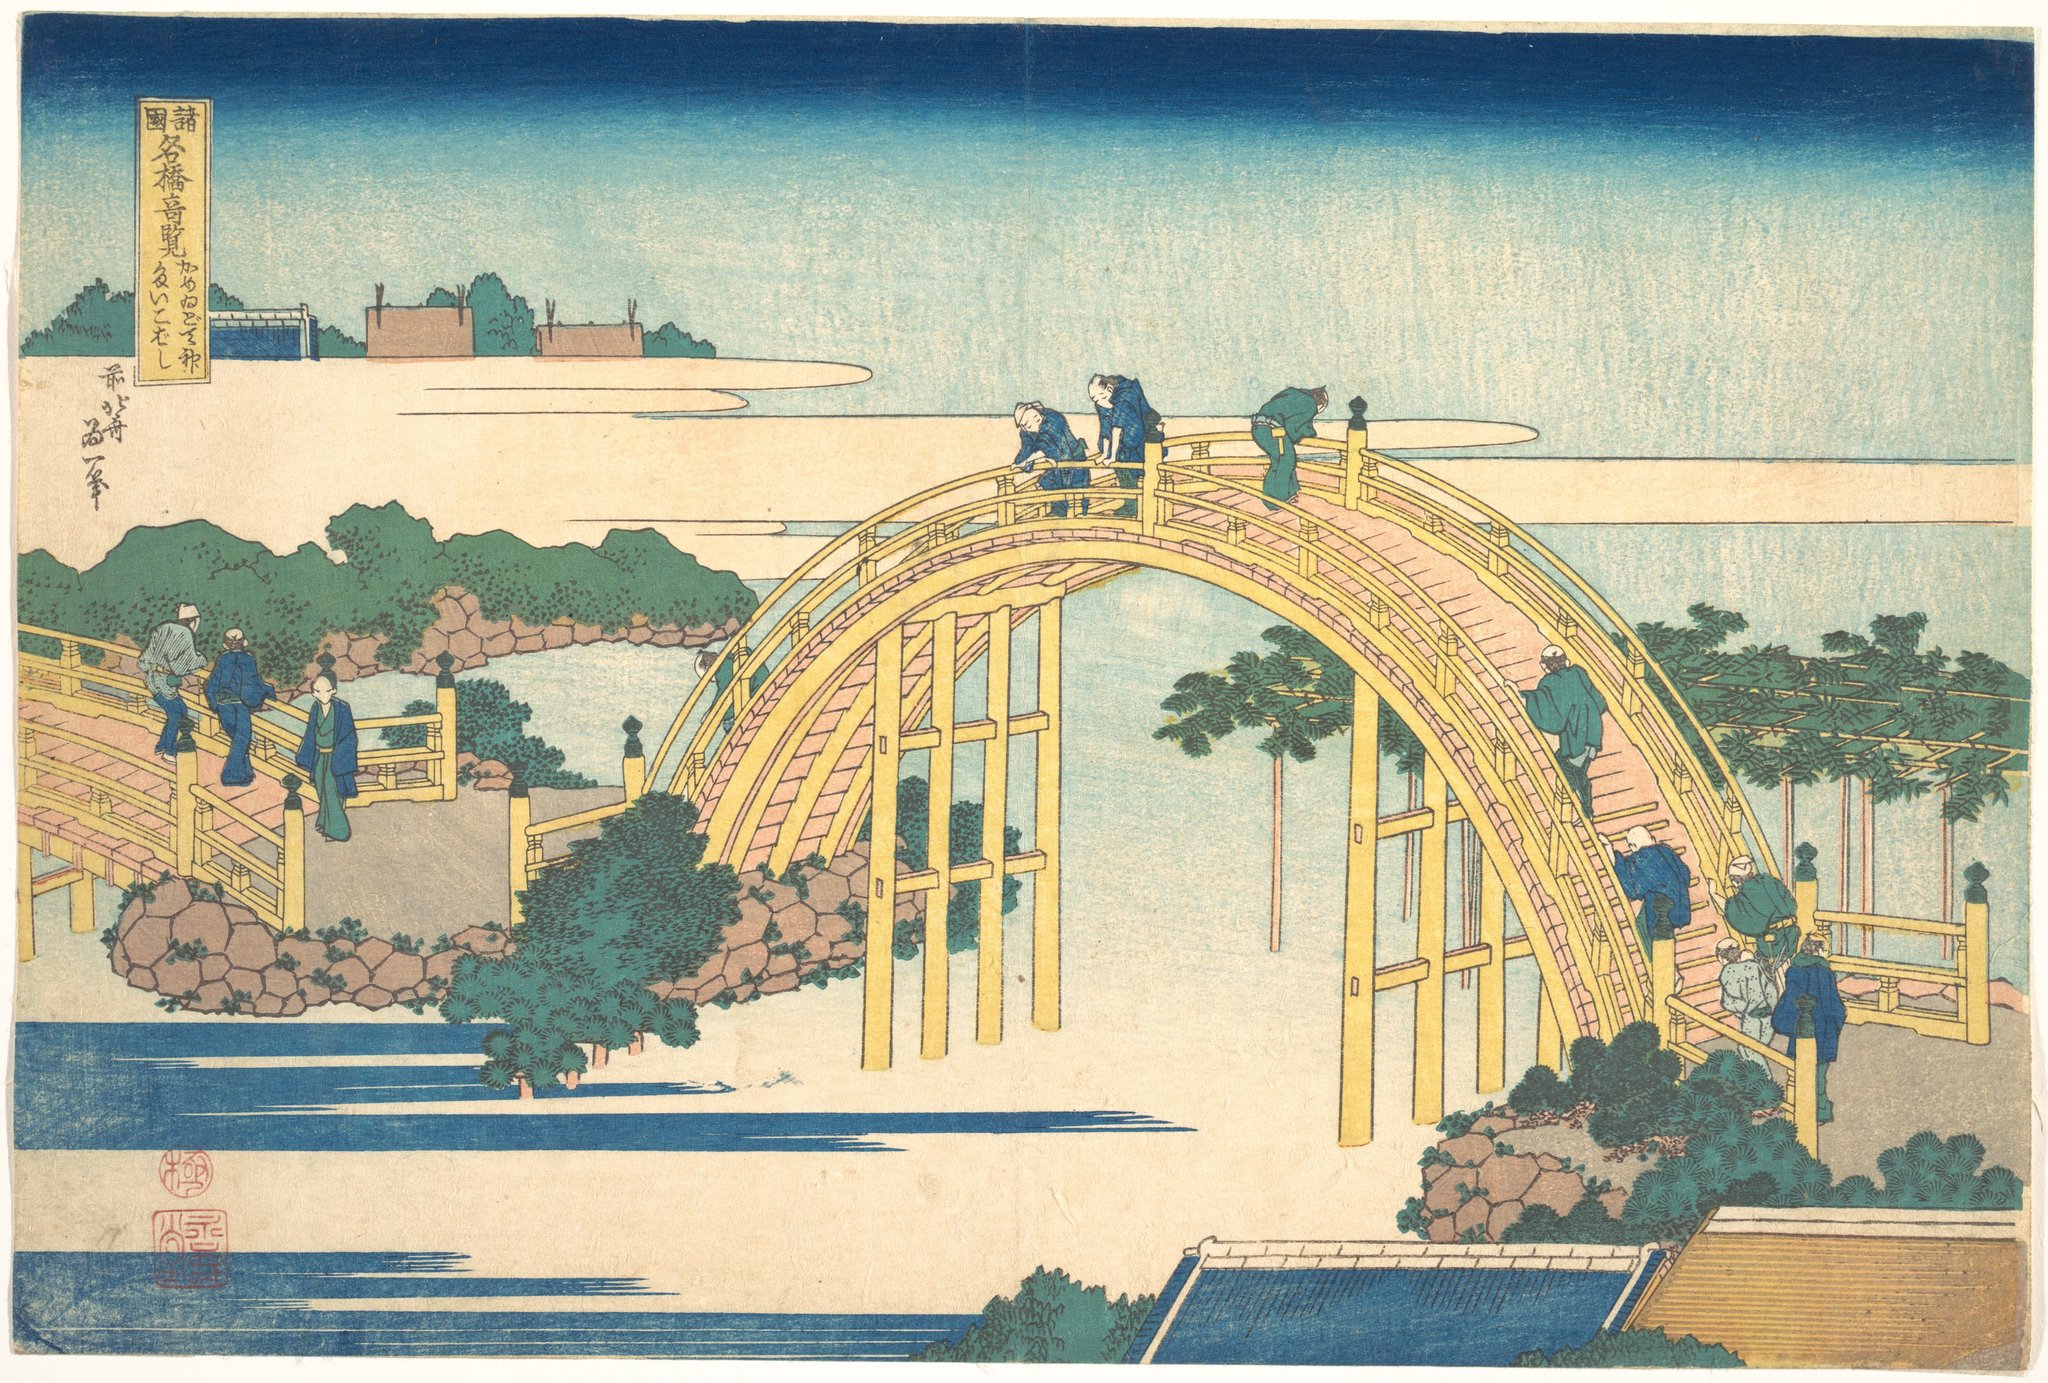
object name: woodblock print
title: The Arched Bridge at Kameido Tenjin Shrine (Kameido Tenjin Taikobashi), from the series Remarkable Views of Bridges in Various Provinces (Shokoku meikyō kiran)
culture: japanese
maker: katsushika hokusai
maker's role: artist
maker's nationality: japanese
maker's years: 1760-1849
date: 1830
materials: ink, paper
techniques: woodblock print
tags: human figures,bridges,trees